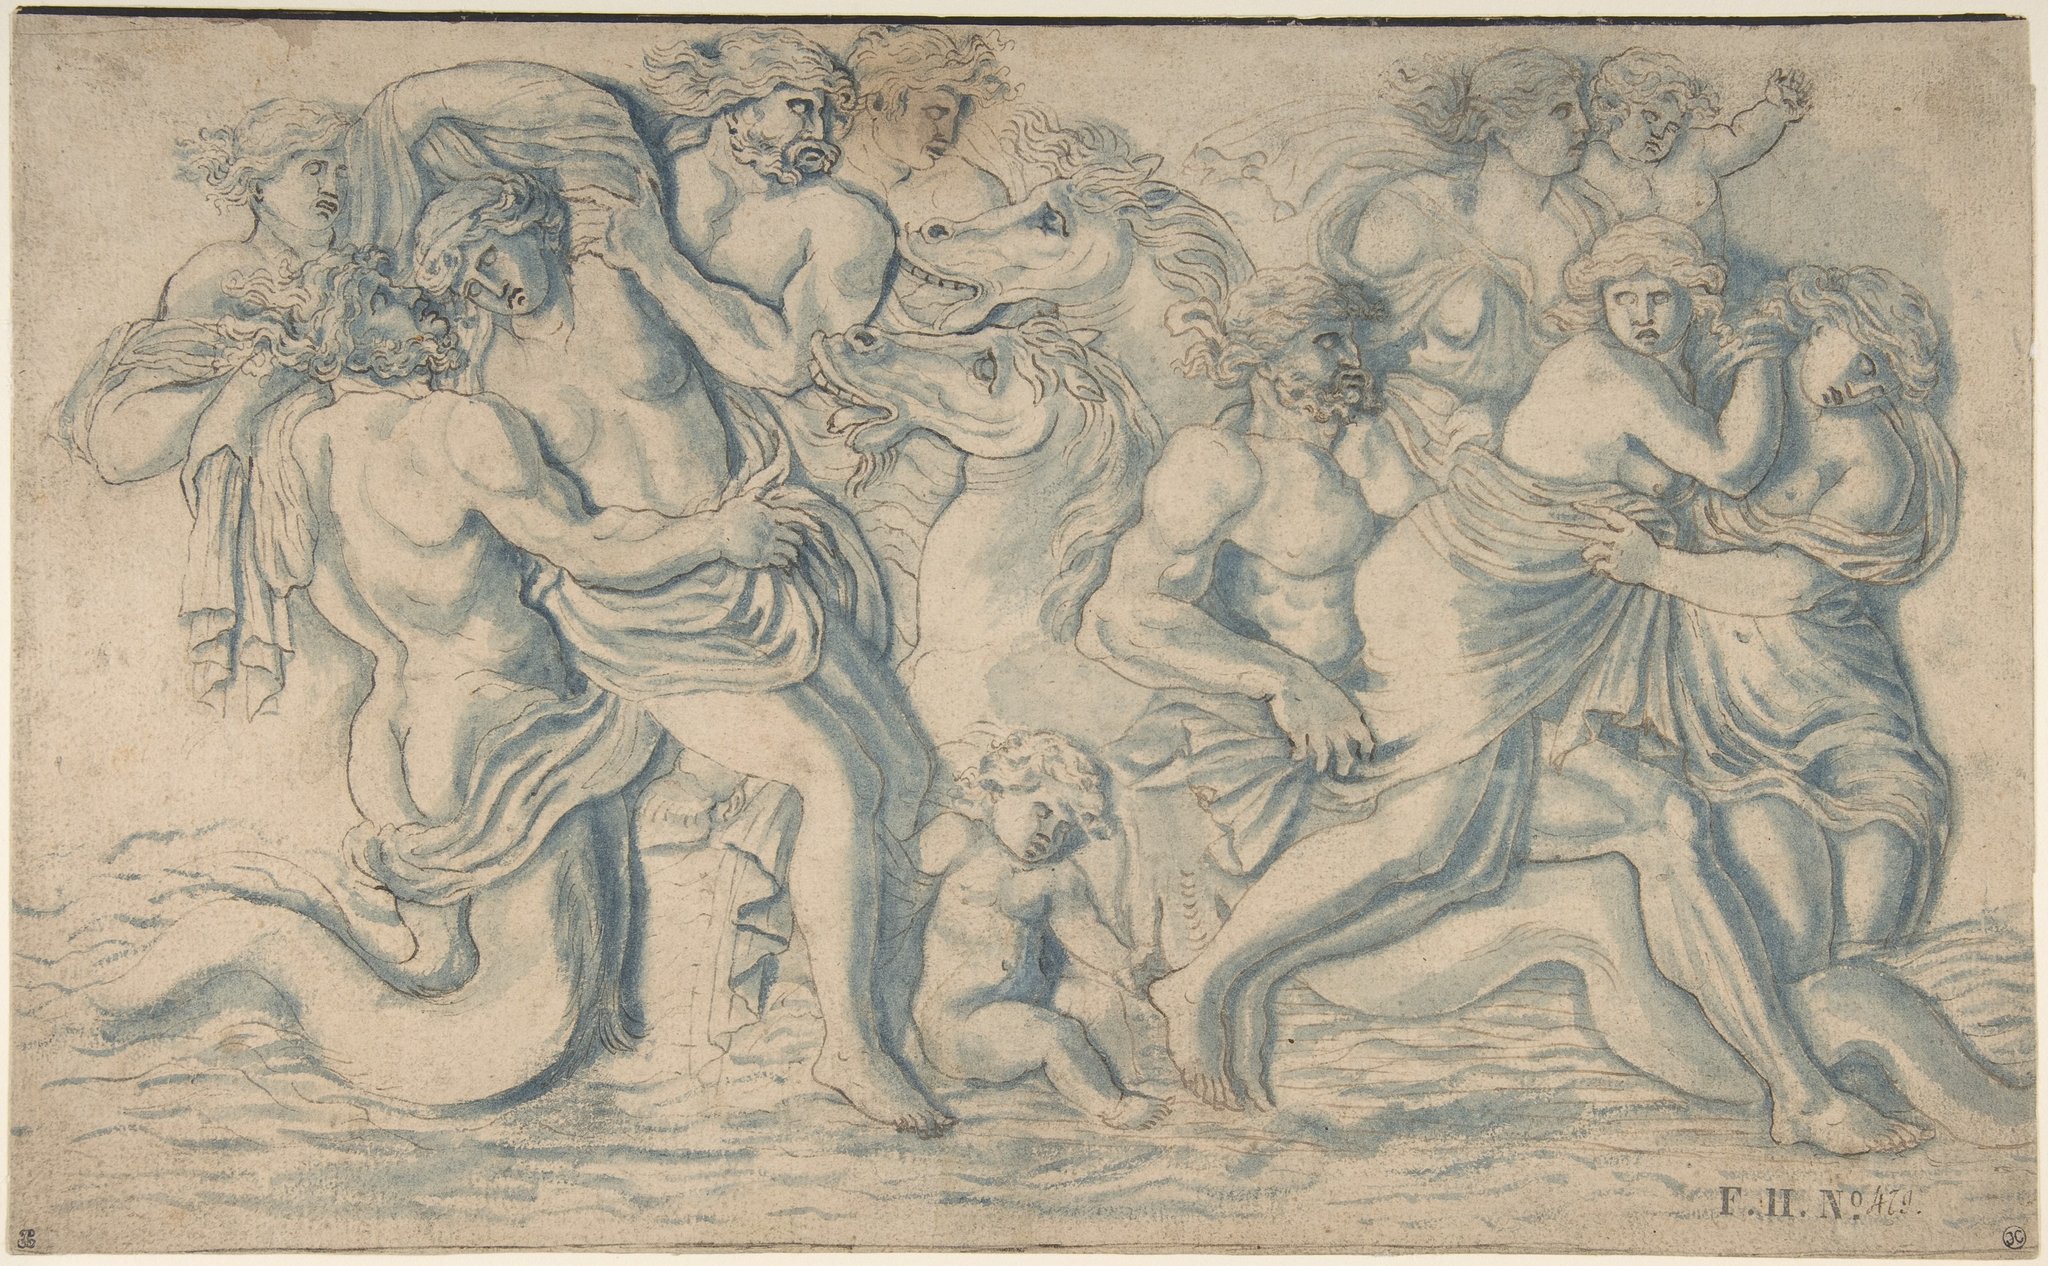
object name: drawing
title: Tritons Carrying Off Nereids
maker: françois perrier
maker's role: artist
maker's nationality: french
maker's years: 1584-1650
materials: ink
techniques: pen, wash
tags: triton,nymphs,horses